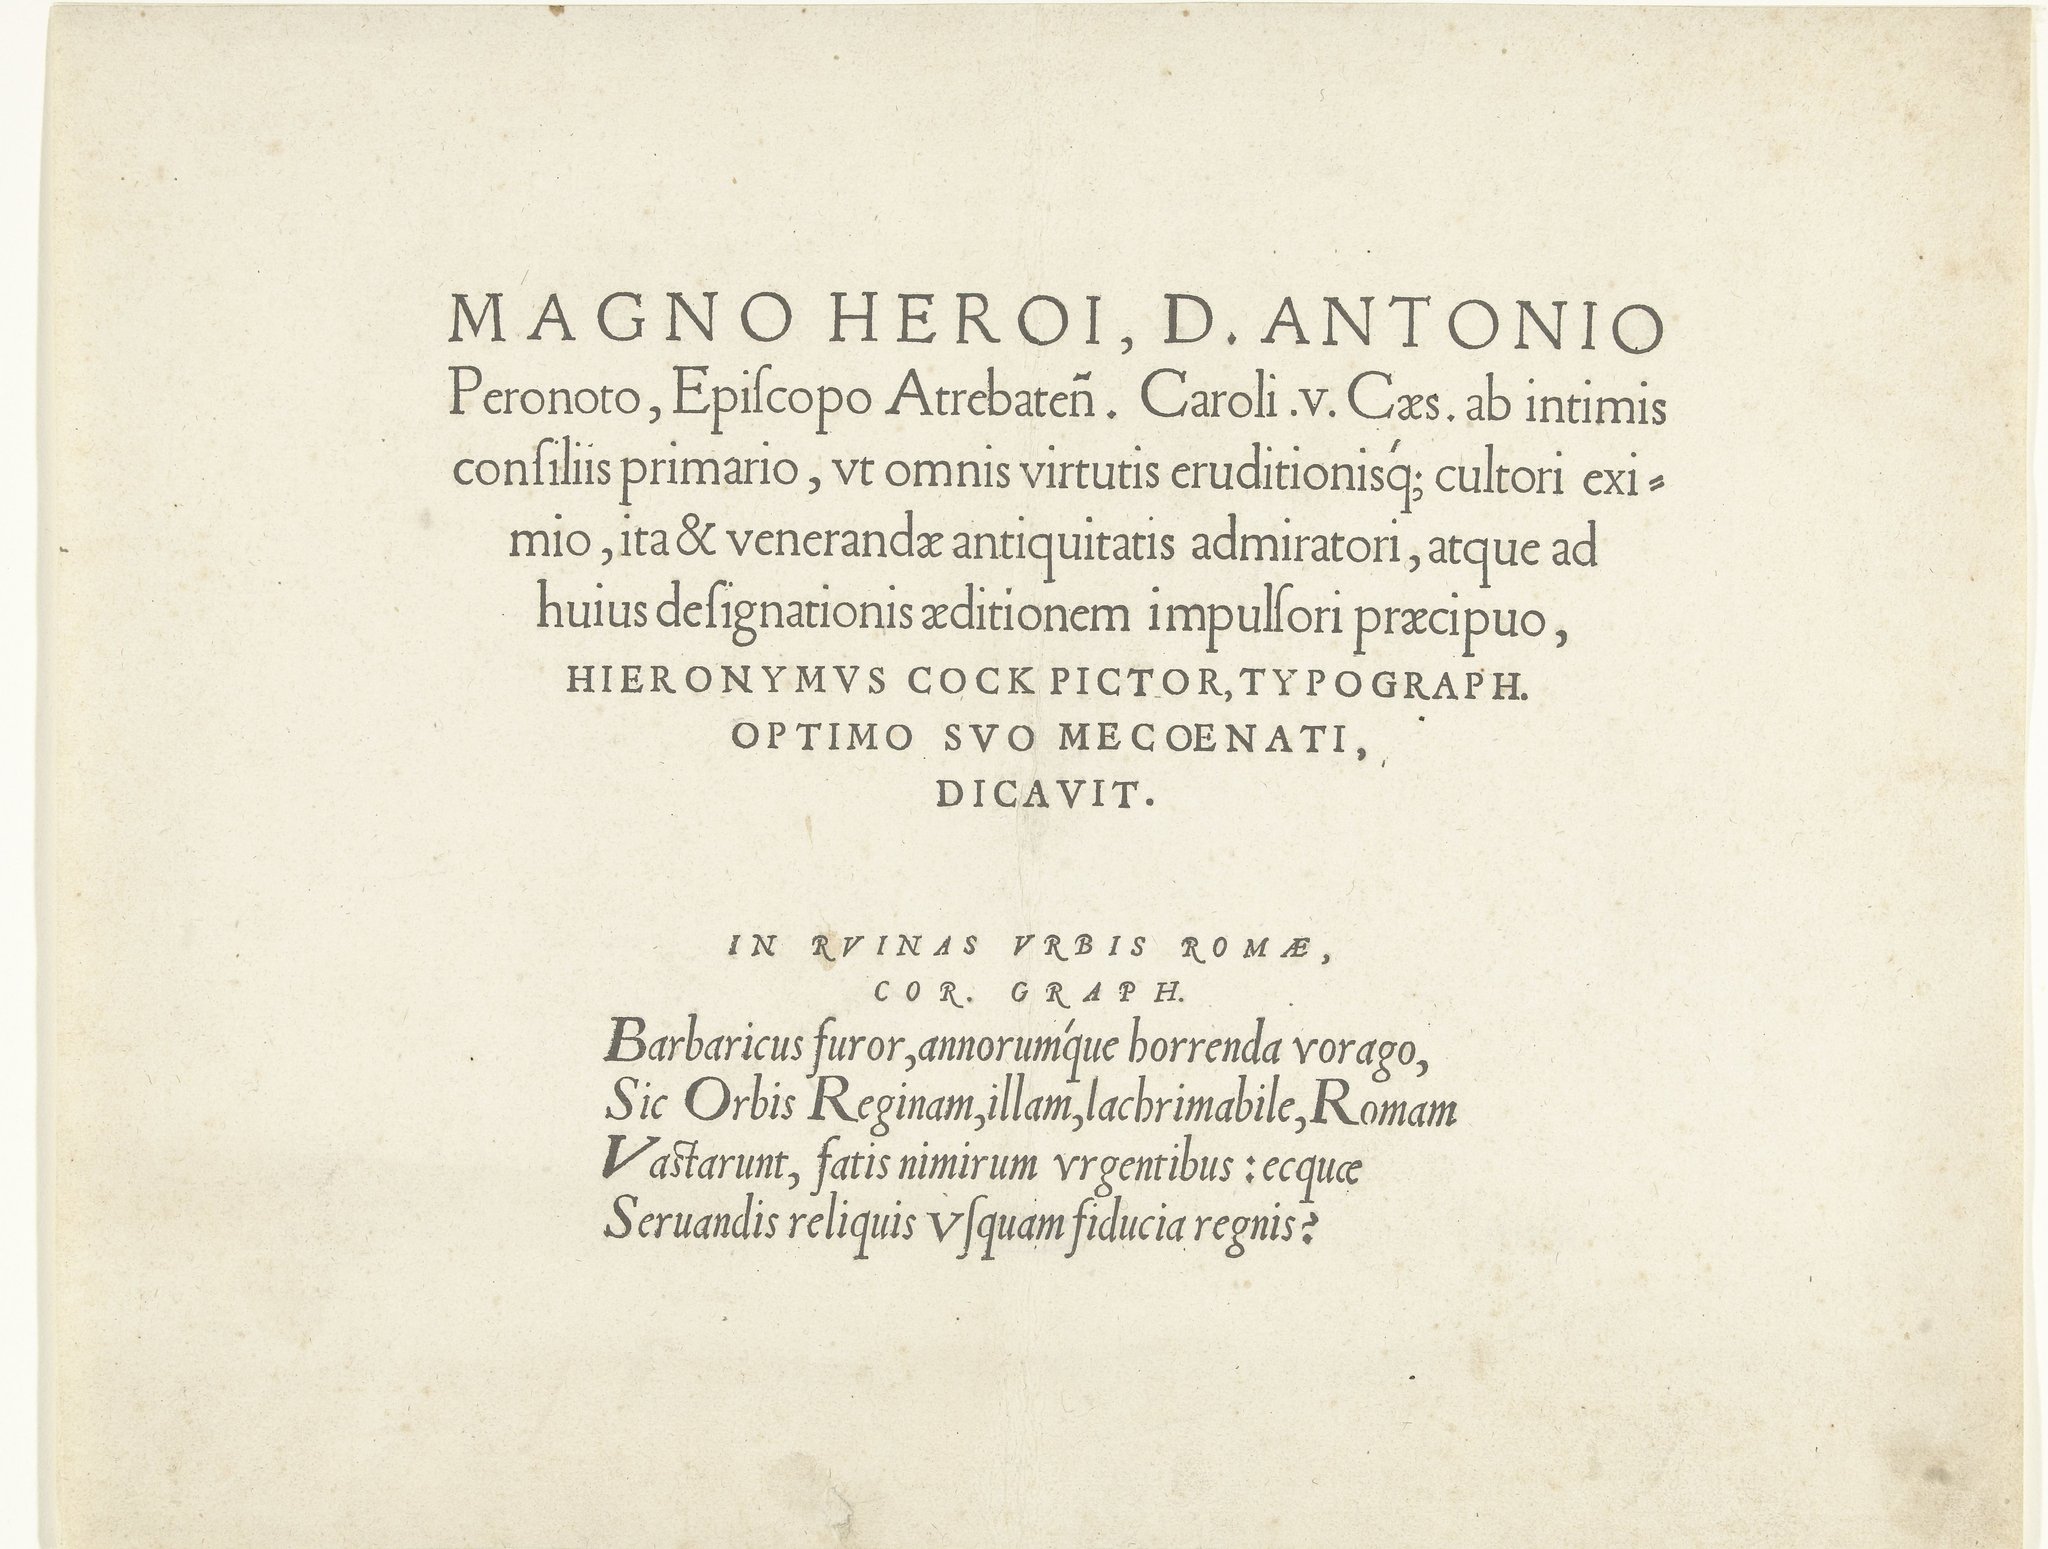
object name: text sheet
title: Praecipua aliquot Romanae antiquitatis ruinarum monimenta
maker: hieronymus cock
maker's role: print maker, publisher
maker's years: 1518-1570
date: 1551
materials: paper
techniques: letterpress printing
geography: antwerp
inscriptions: collector's mark: Lugt 2228